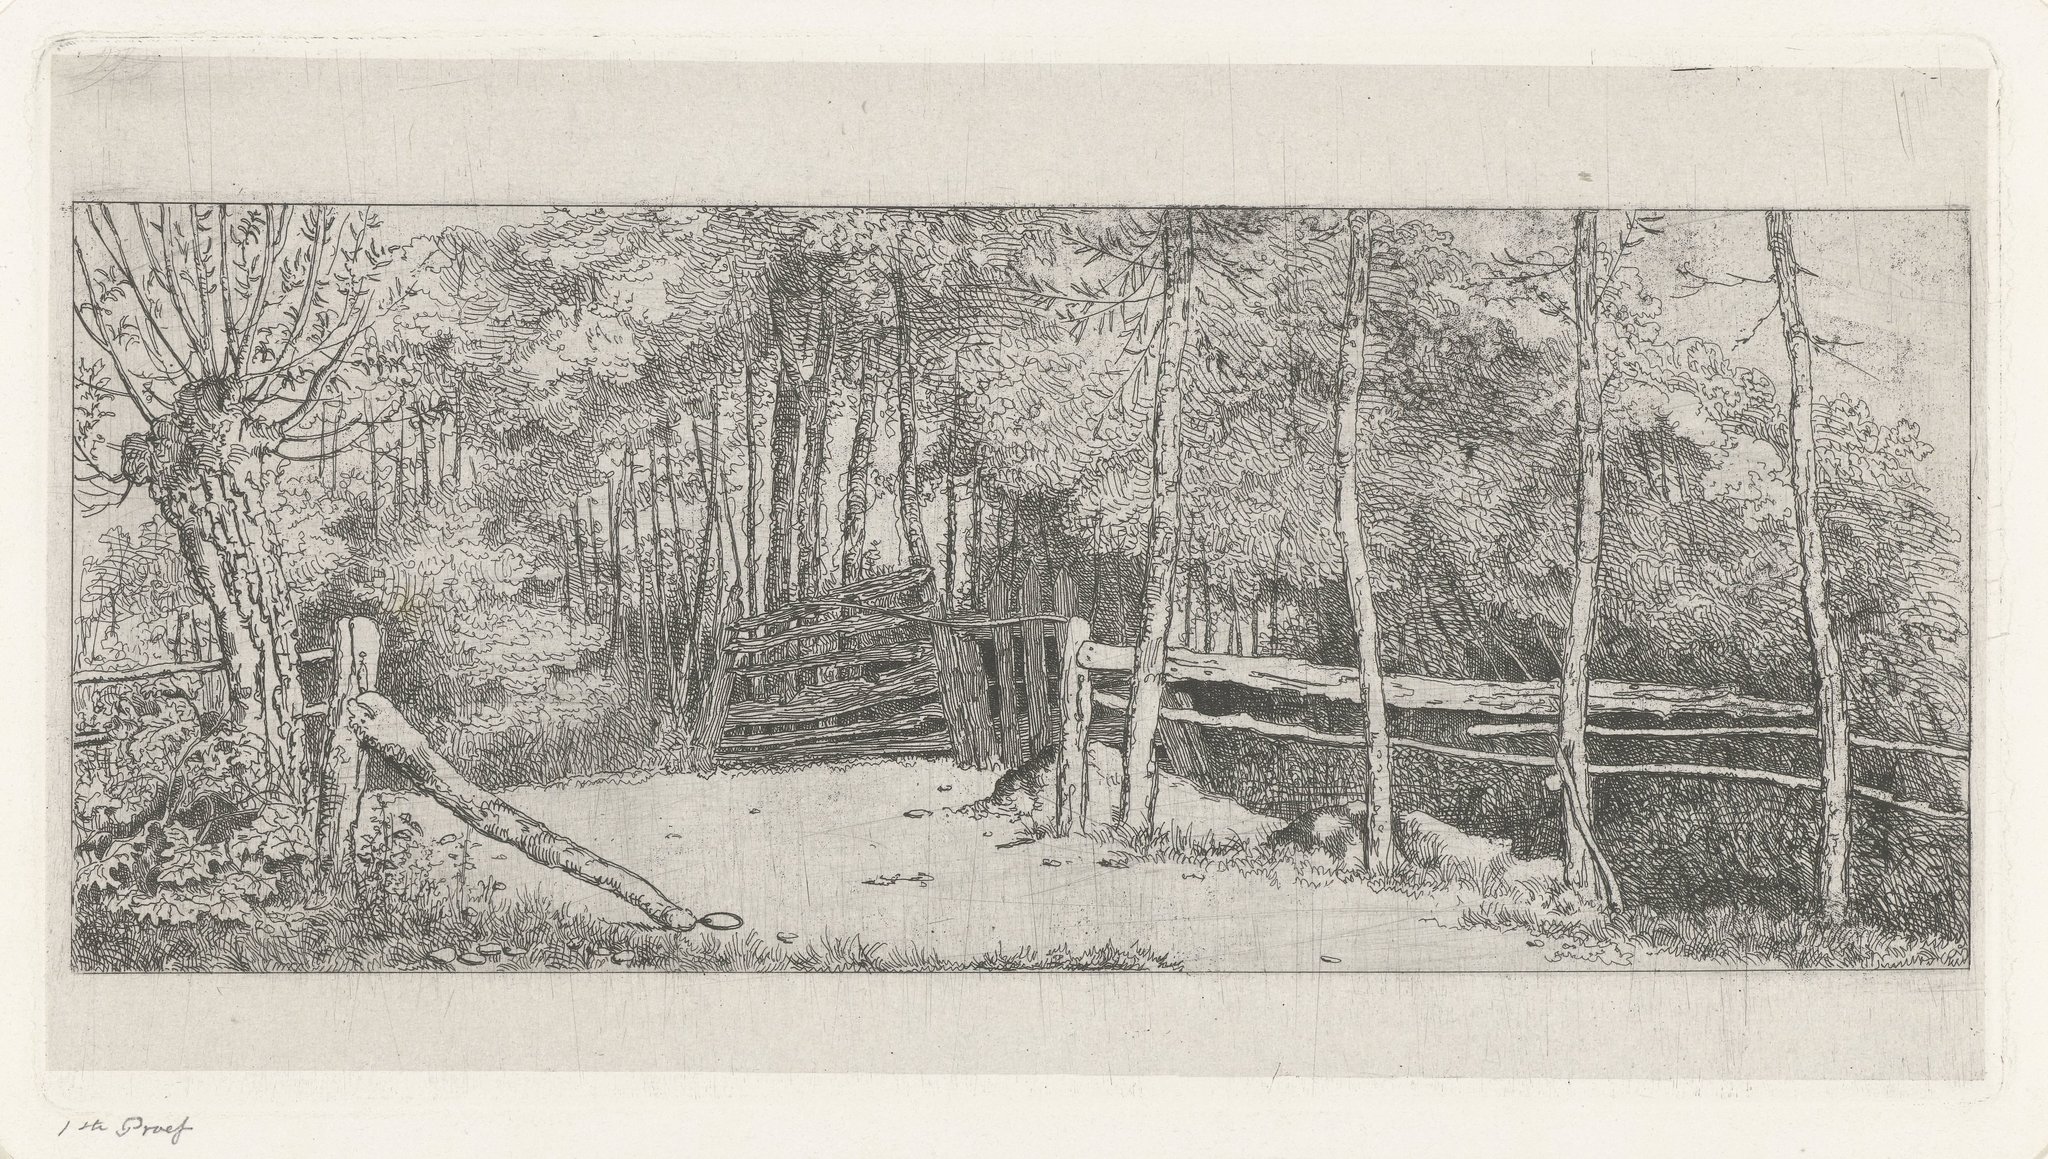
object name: print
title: Weggetje langs een bos te Cronensteyn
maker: jacobus ludovicus cornet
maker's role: draughtsman, print maker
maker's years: 1815-1882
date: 1825-1882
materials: paper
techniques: etching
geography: leiden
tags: forest path or lane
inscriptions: collector's mark: Lugt 2166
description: Een weggetje langs een bos nabij het gebied Cronesteyn te Leiden. Links een knotwilg.